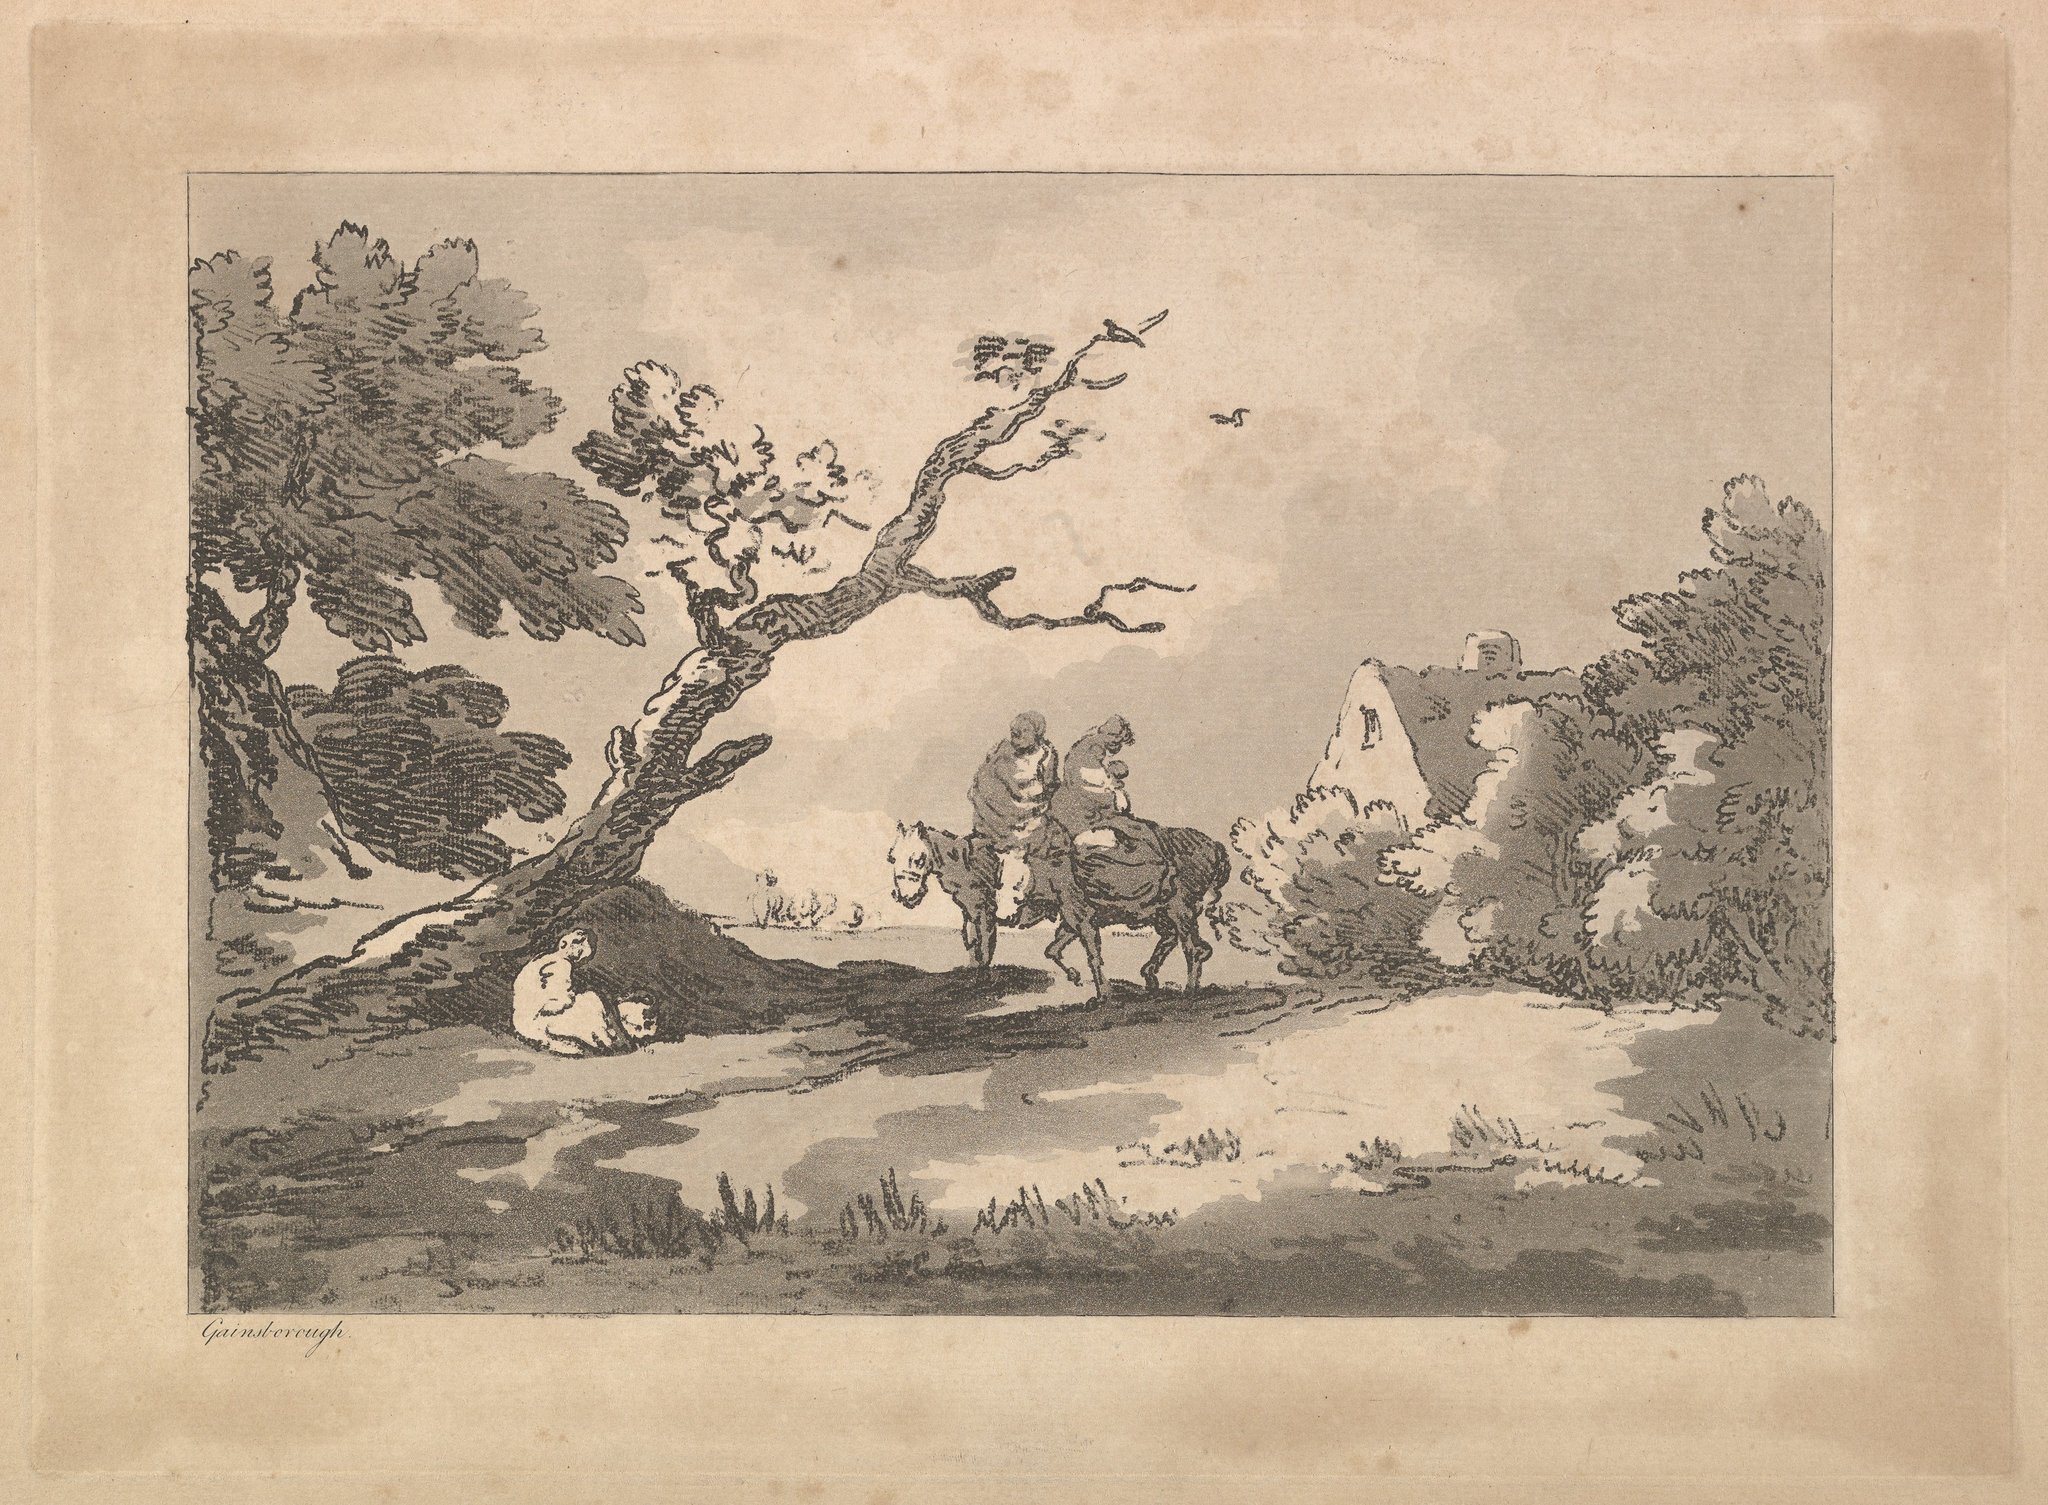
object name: print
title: Landscape with Figures on Horseback, Another Resting Under a Gnarled Tree, and a Cottage at Right Nestled in Trees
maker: thomas rowlandson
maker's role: artist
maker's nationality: british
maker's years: 1757-1827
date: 1784-1788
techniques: aquatint, etching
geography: england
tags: horses,landscapes,trees